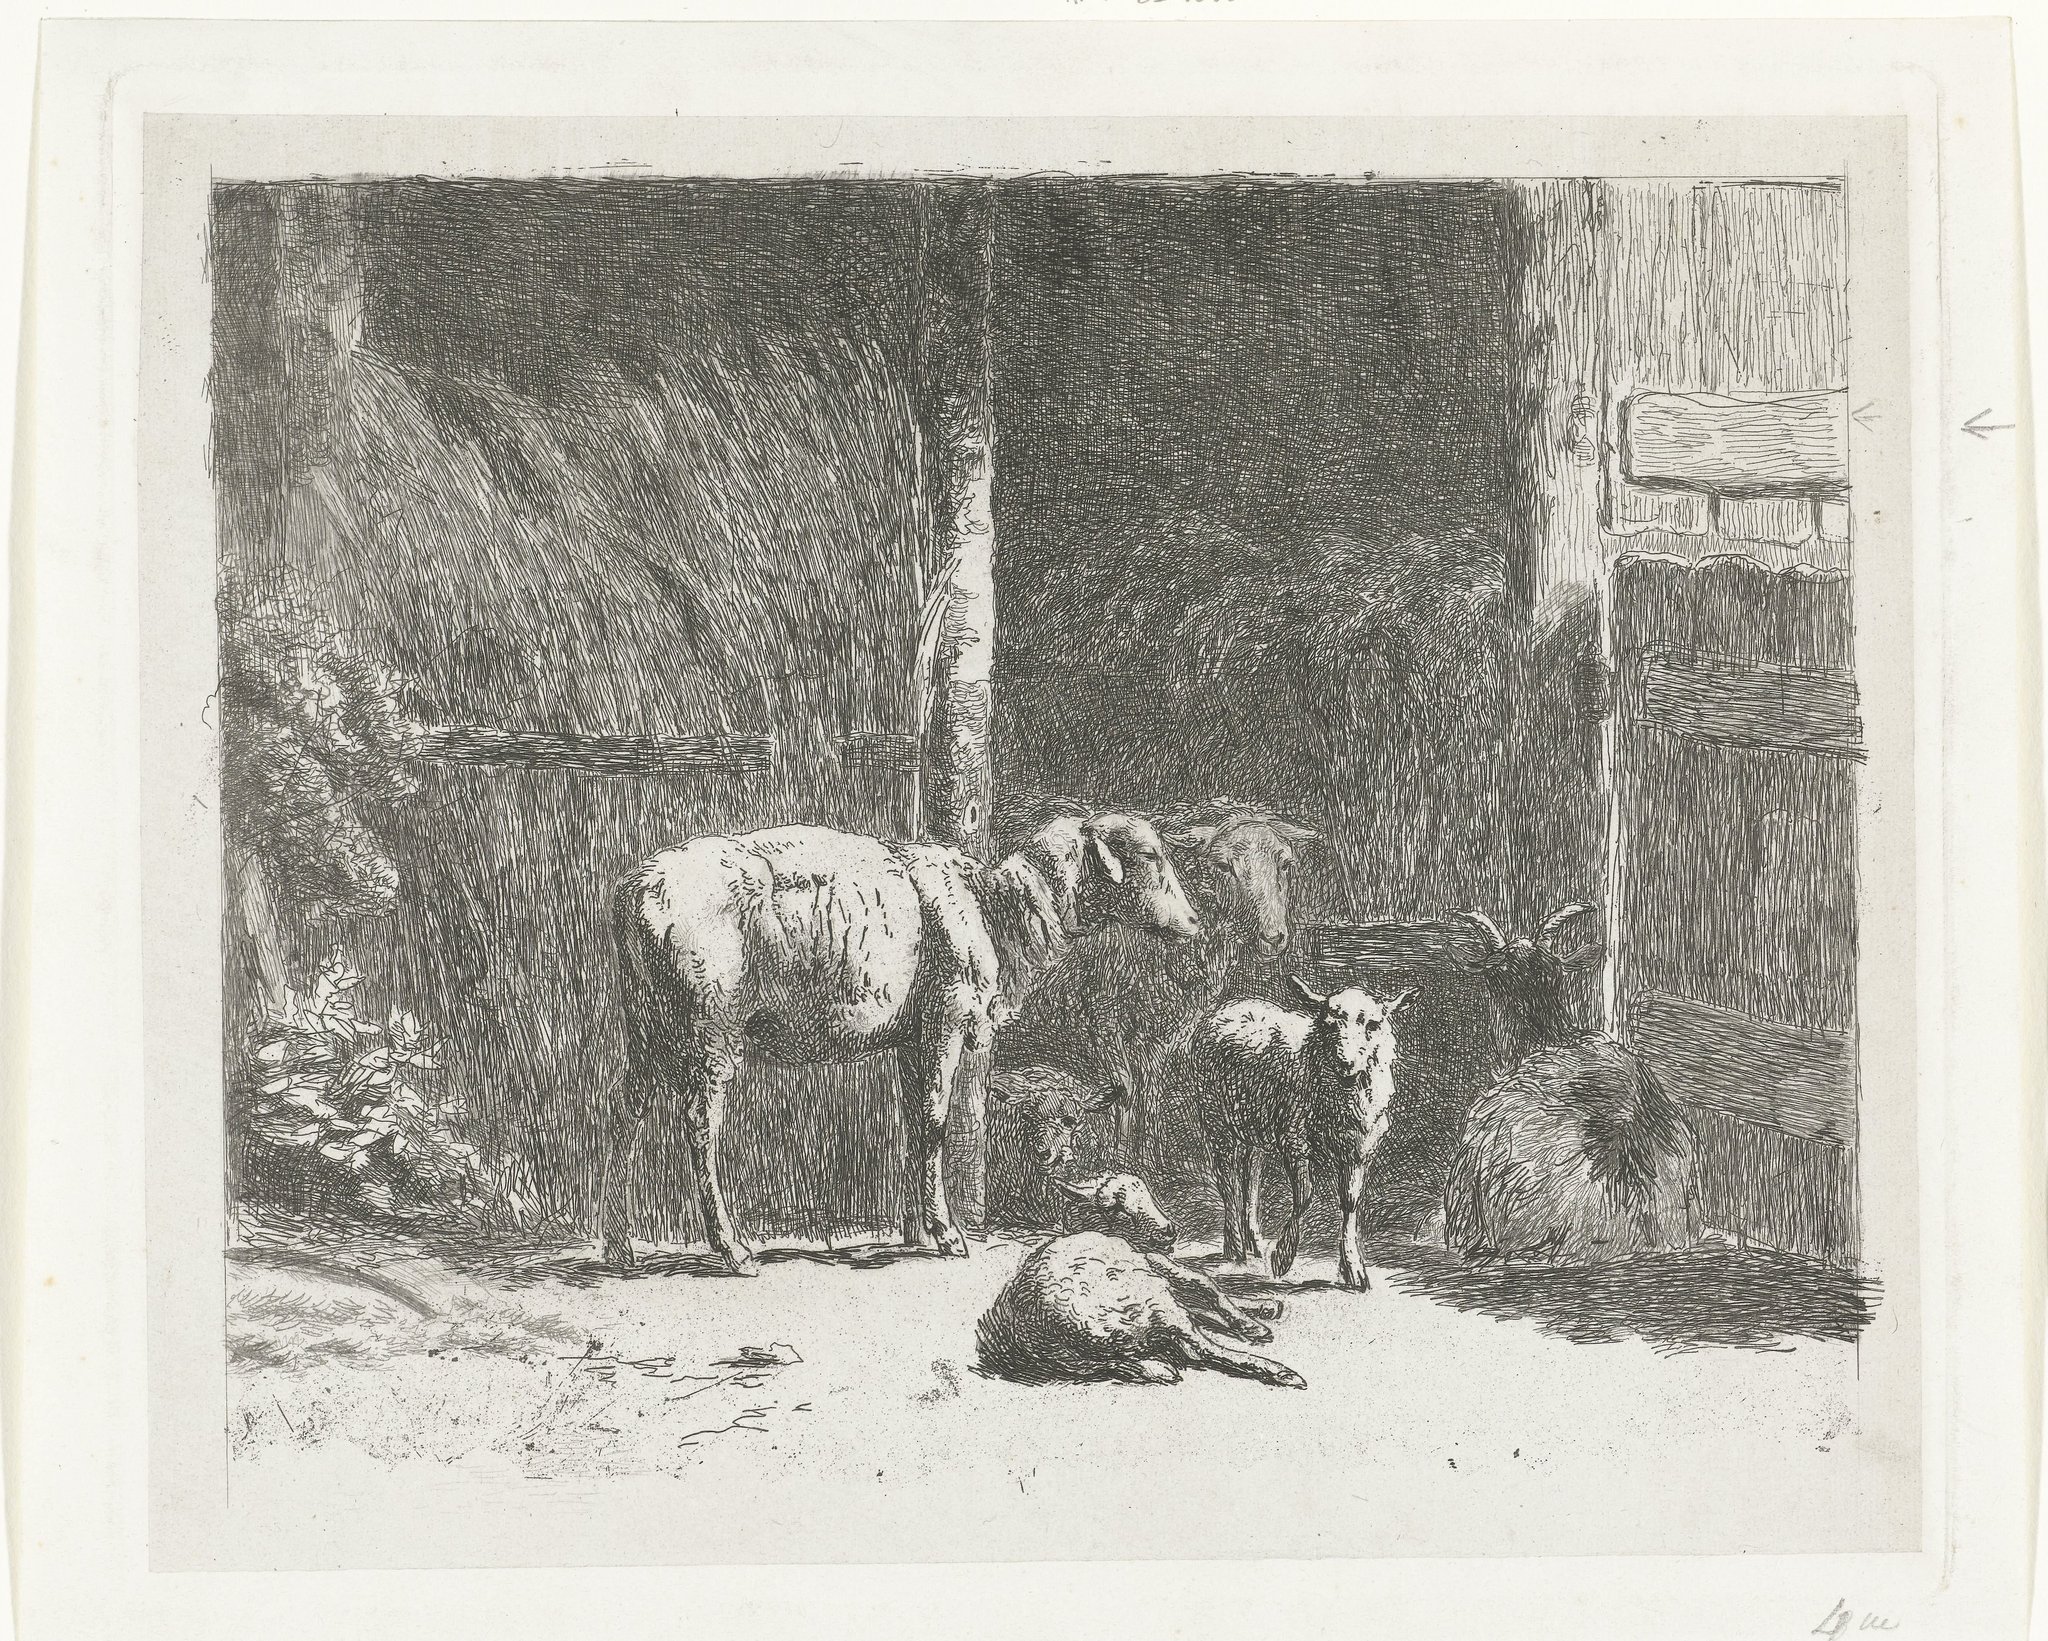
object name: print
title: Schapen en lammeren en liggende bok bij stal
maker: simon van den berg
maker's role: draughtsman, print maker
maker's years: 1812-1891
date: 1822-1899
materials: paper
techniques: drypoint, etching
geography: netherlands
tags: he-goat, billy-goat, sheep, man and animal (+ stable, shed, kennel)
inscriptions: collector's mark: Lugt 2228